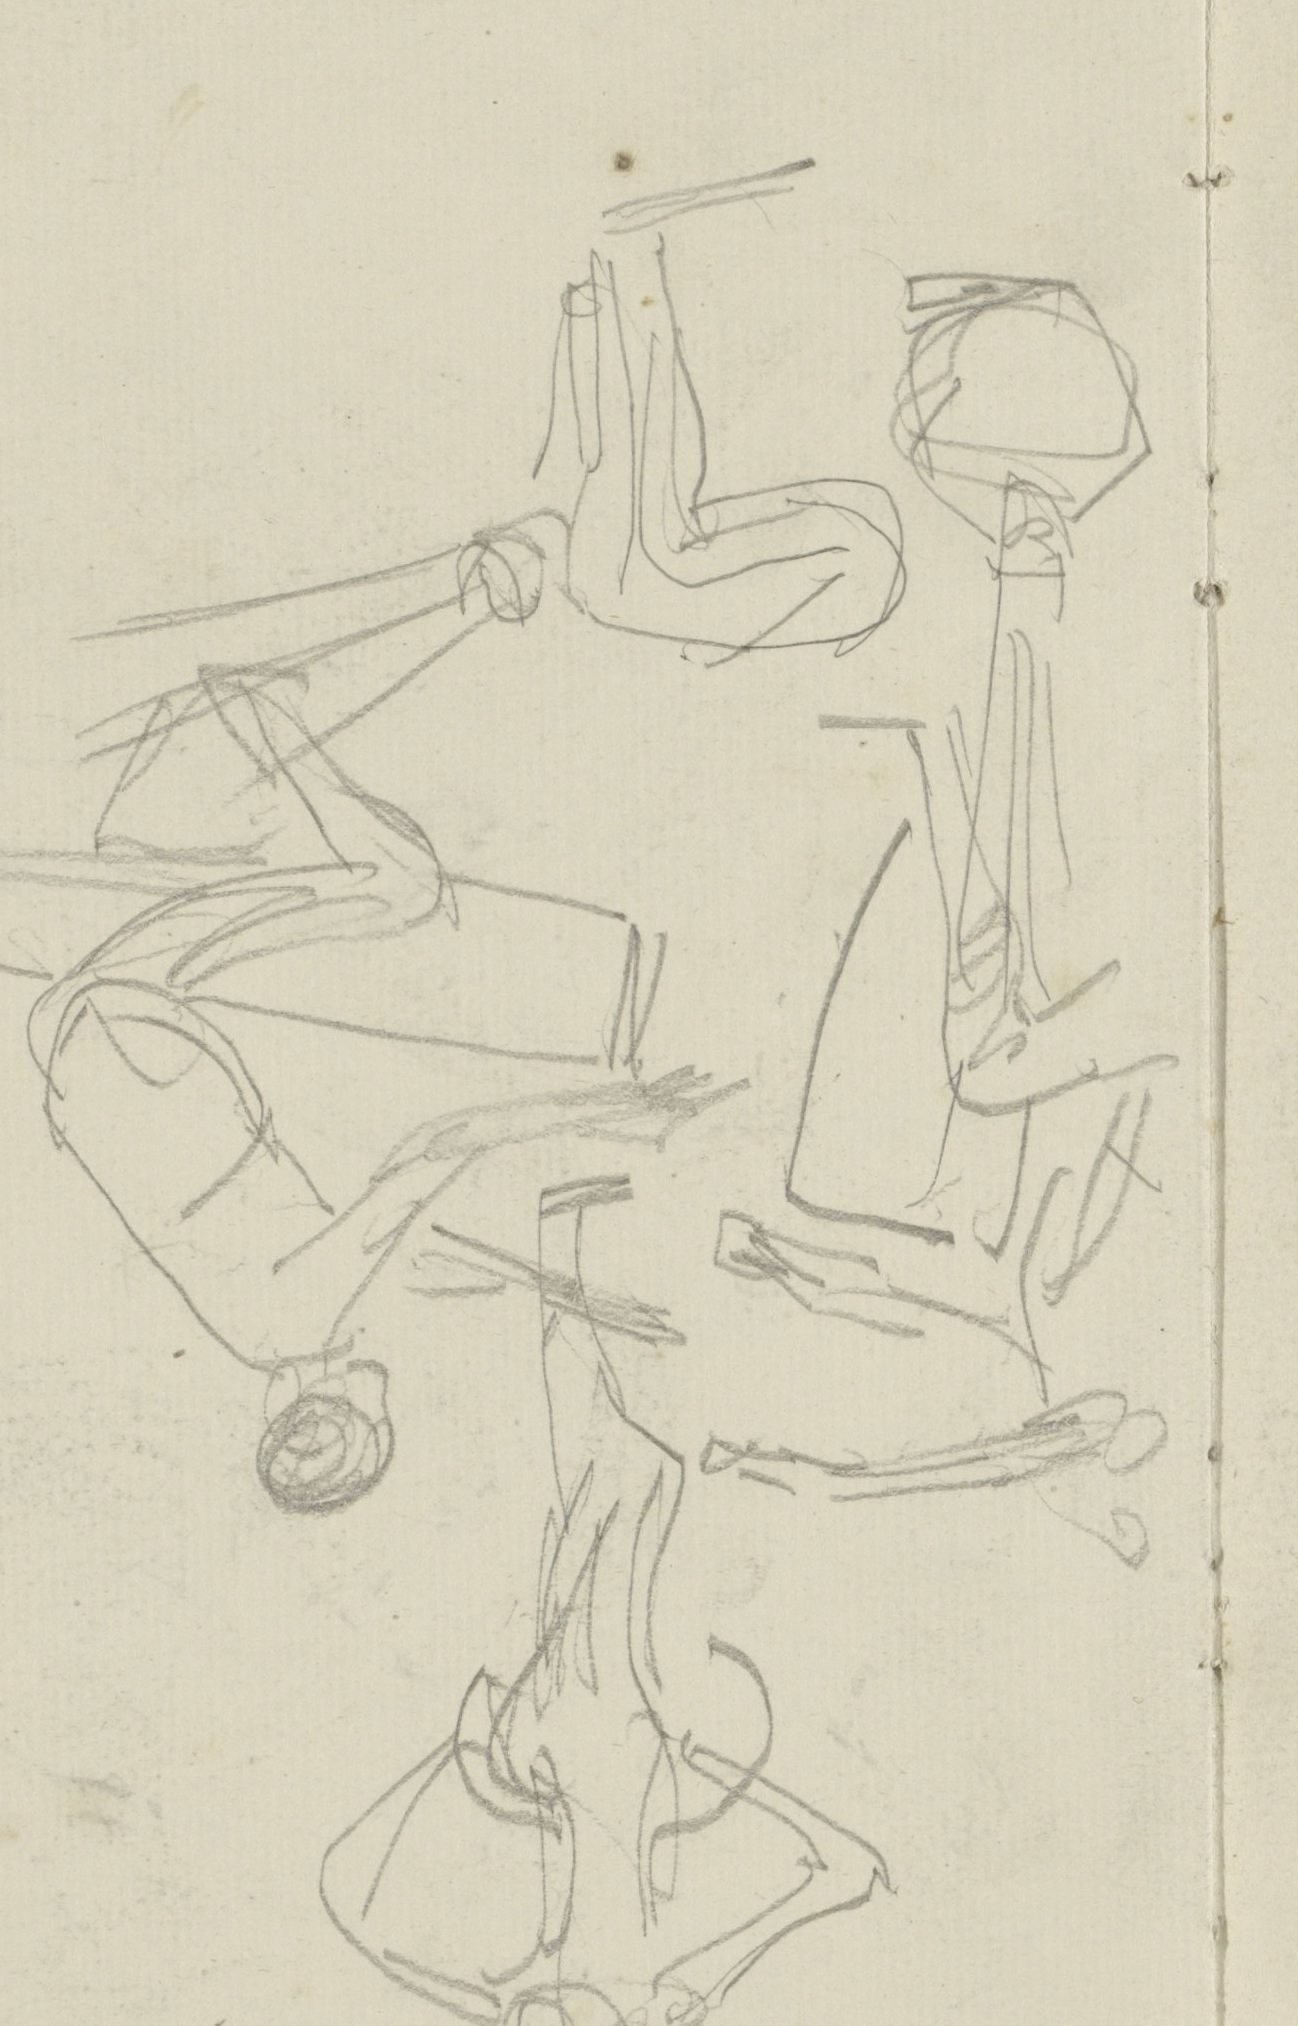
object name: sketchbook leaf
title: Figuurstudies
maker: george hendrik breitner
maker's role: draughtsman, painter, print maker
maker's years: 1857-1923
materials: paper, pencil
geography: the hague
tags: standing figure, bending figure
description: Pagina 31 uit een schetsboek met 28 bladen.